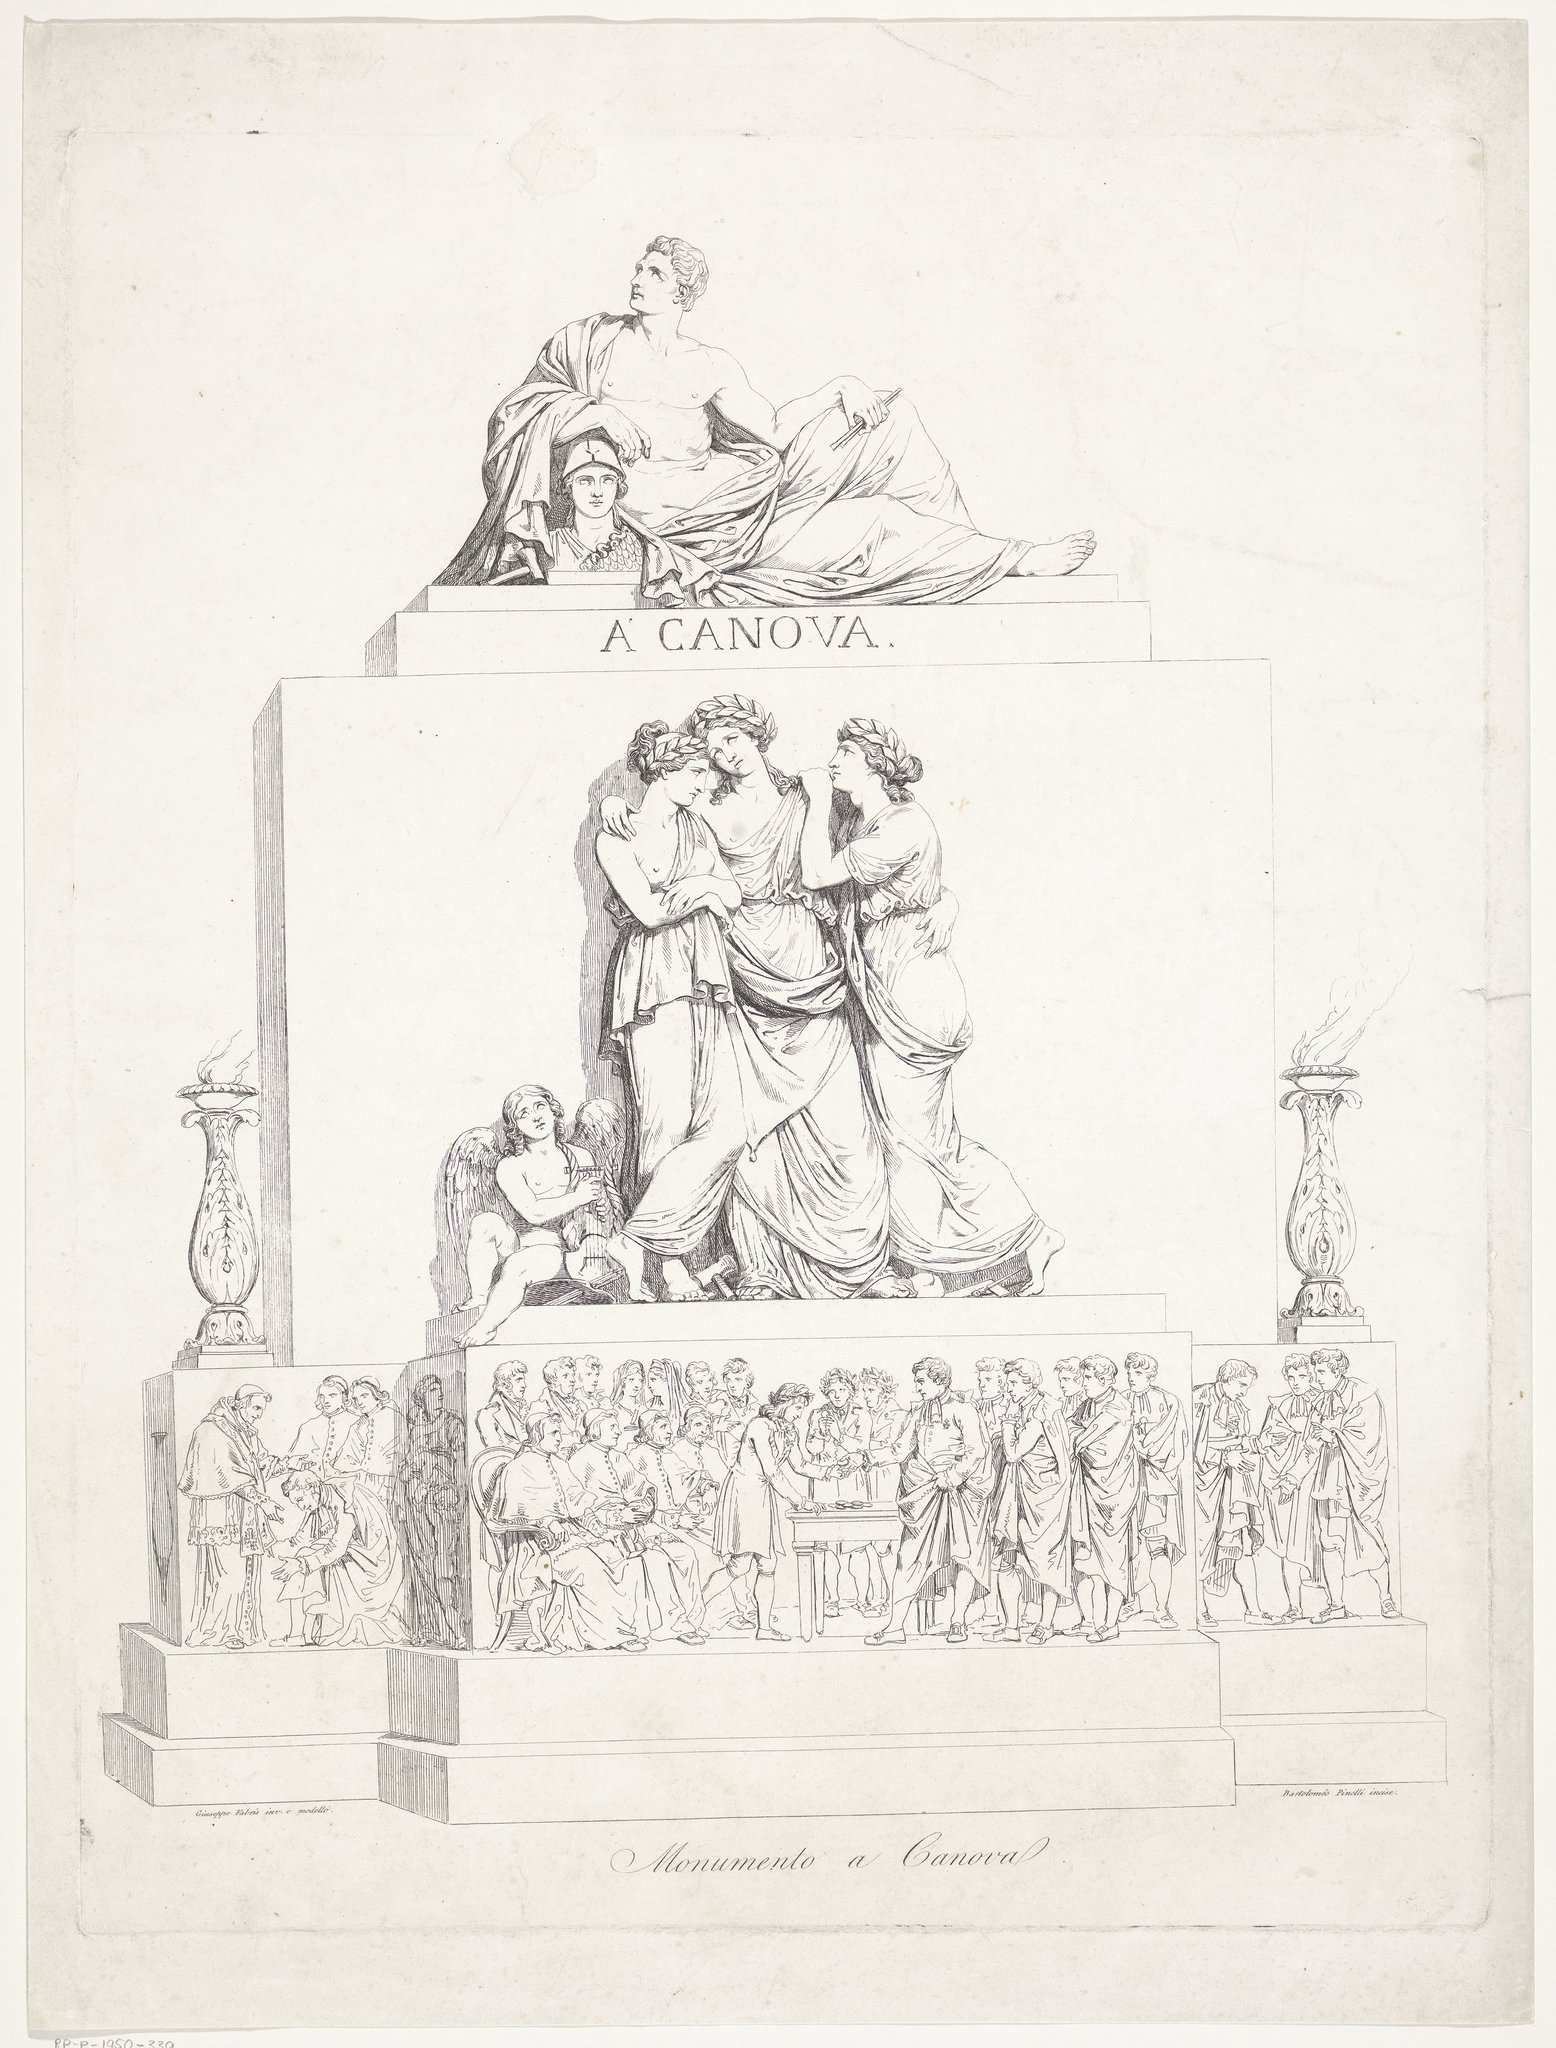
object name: print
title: Monument voor beeldhouwer Antonio Canova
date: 1791-1835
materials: paper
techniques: etching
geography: italy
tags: venice, painter, draughtsman, antonio canova, graces (charites), generally three in number; 'gratie' (ripa), monument, statue, portrait, self-portrait of artist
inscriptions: collector's mark: Lugt 2228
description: Een monument voor de Italiaanse beeldhouwer Antonio Canova. Een monument bestaande uit drie lagen. De onderste laag bevat een fries met geestelijken en mannen die een deal sluiten. De middelste laag toont de Drie Gratiën treurend. Bovenop een beeld van de liggende kunstenaar.